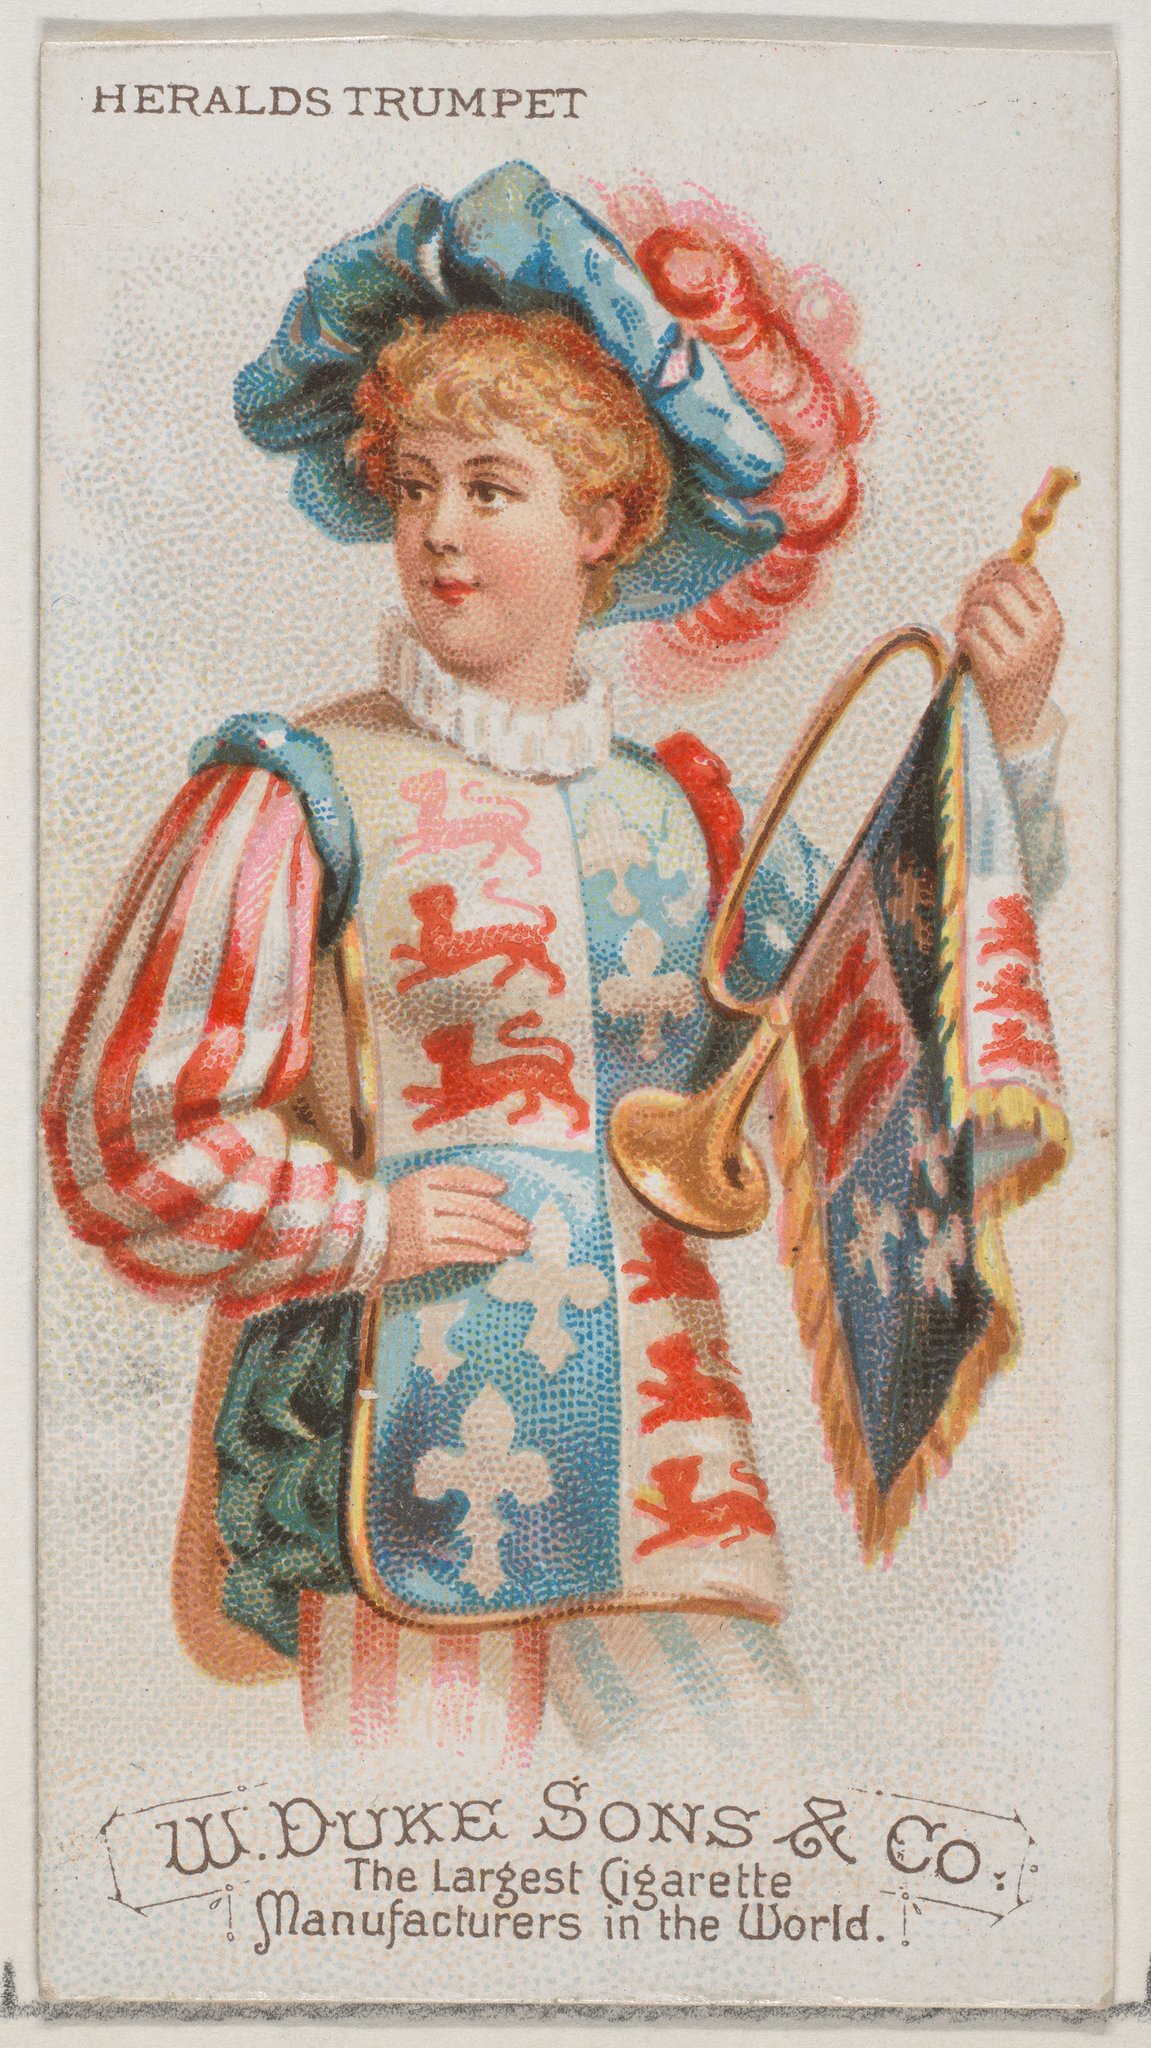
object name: print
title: Heralds Trumpet, from the Musical Instruments series (N82) for Duke brand cigarettes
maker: w. duke, sons & co.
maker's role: publisher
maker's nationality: american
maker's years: 1870-1920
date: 1888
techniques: color lithograph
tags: women,trumpets,musicians